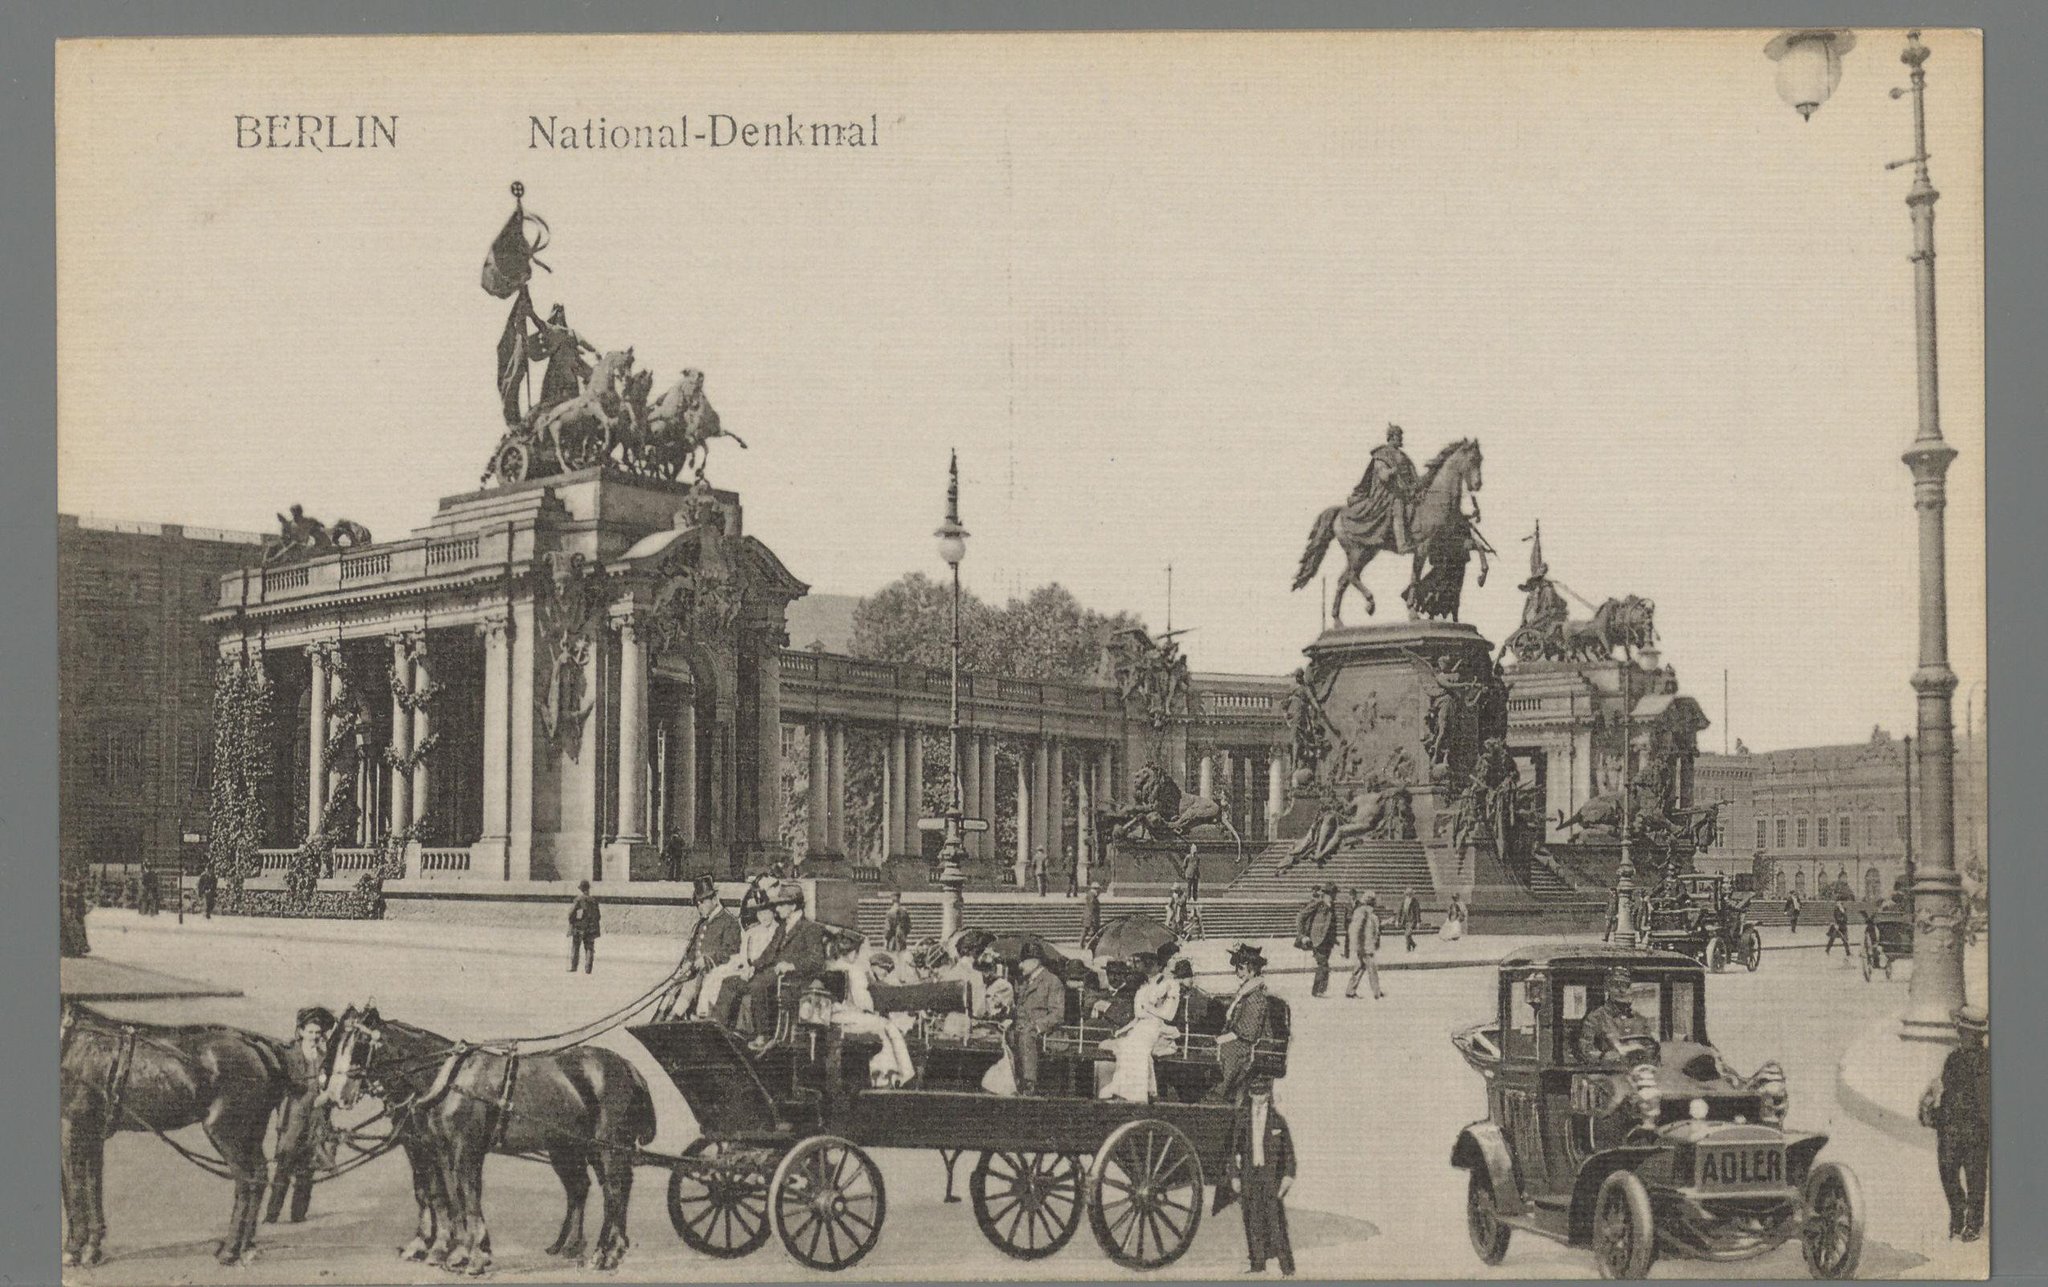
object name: photomechanical print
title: Berlin. National-Denkmal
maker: Anonymous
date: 1905-1930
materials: cardboard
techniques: photograph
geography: berlin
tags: berlin, wilhelm i (keizer van duitsland), monument, statue